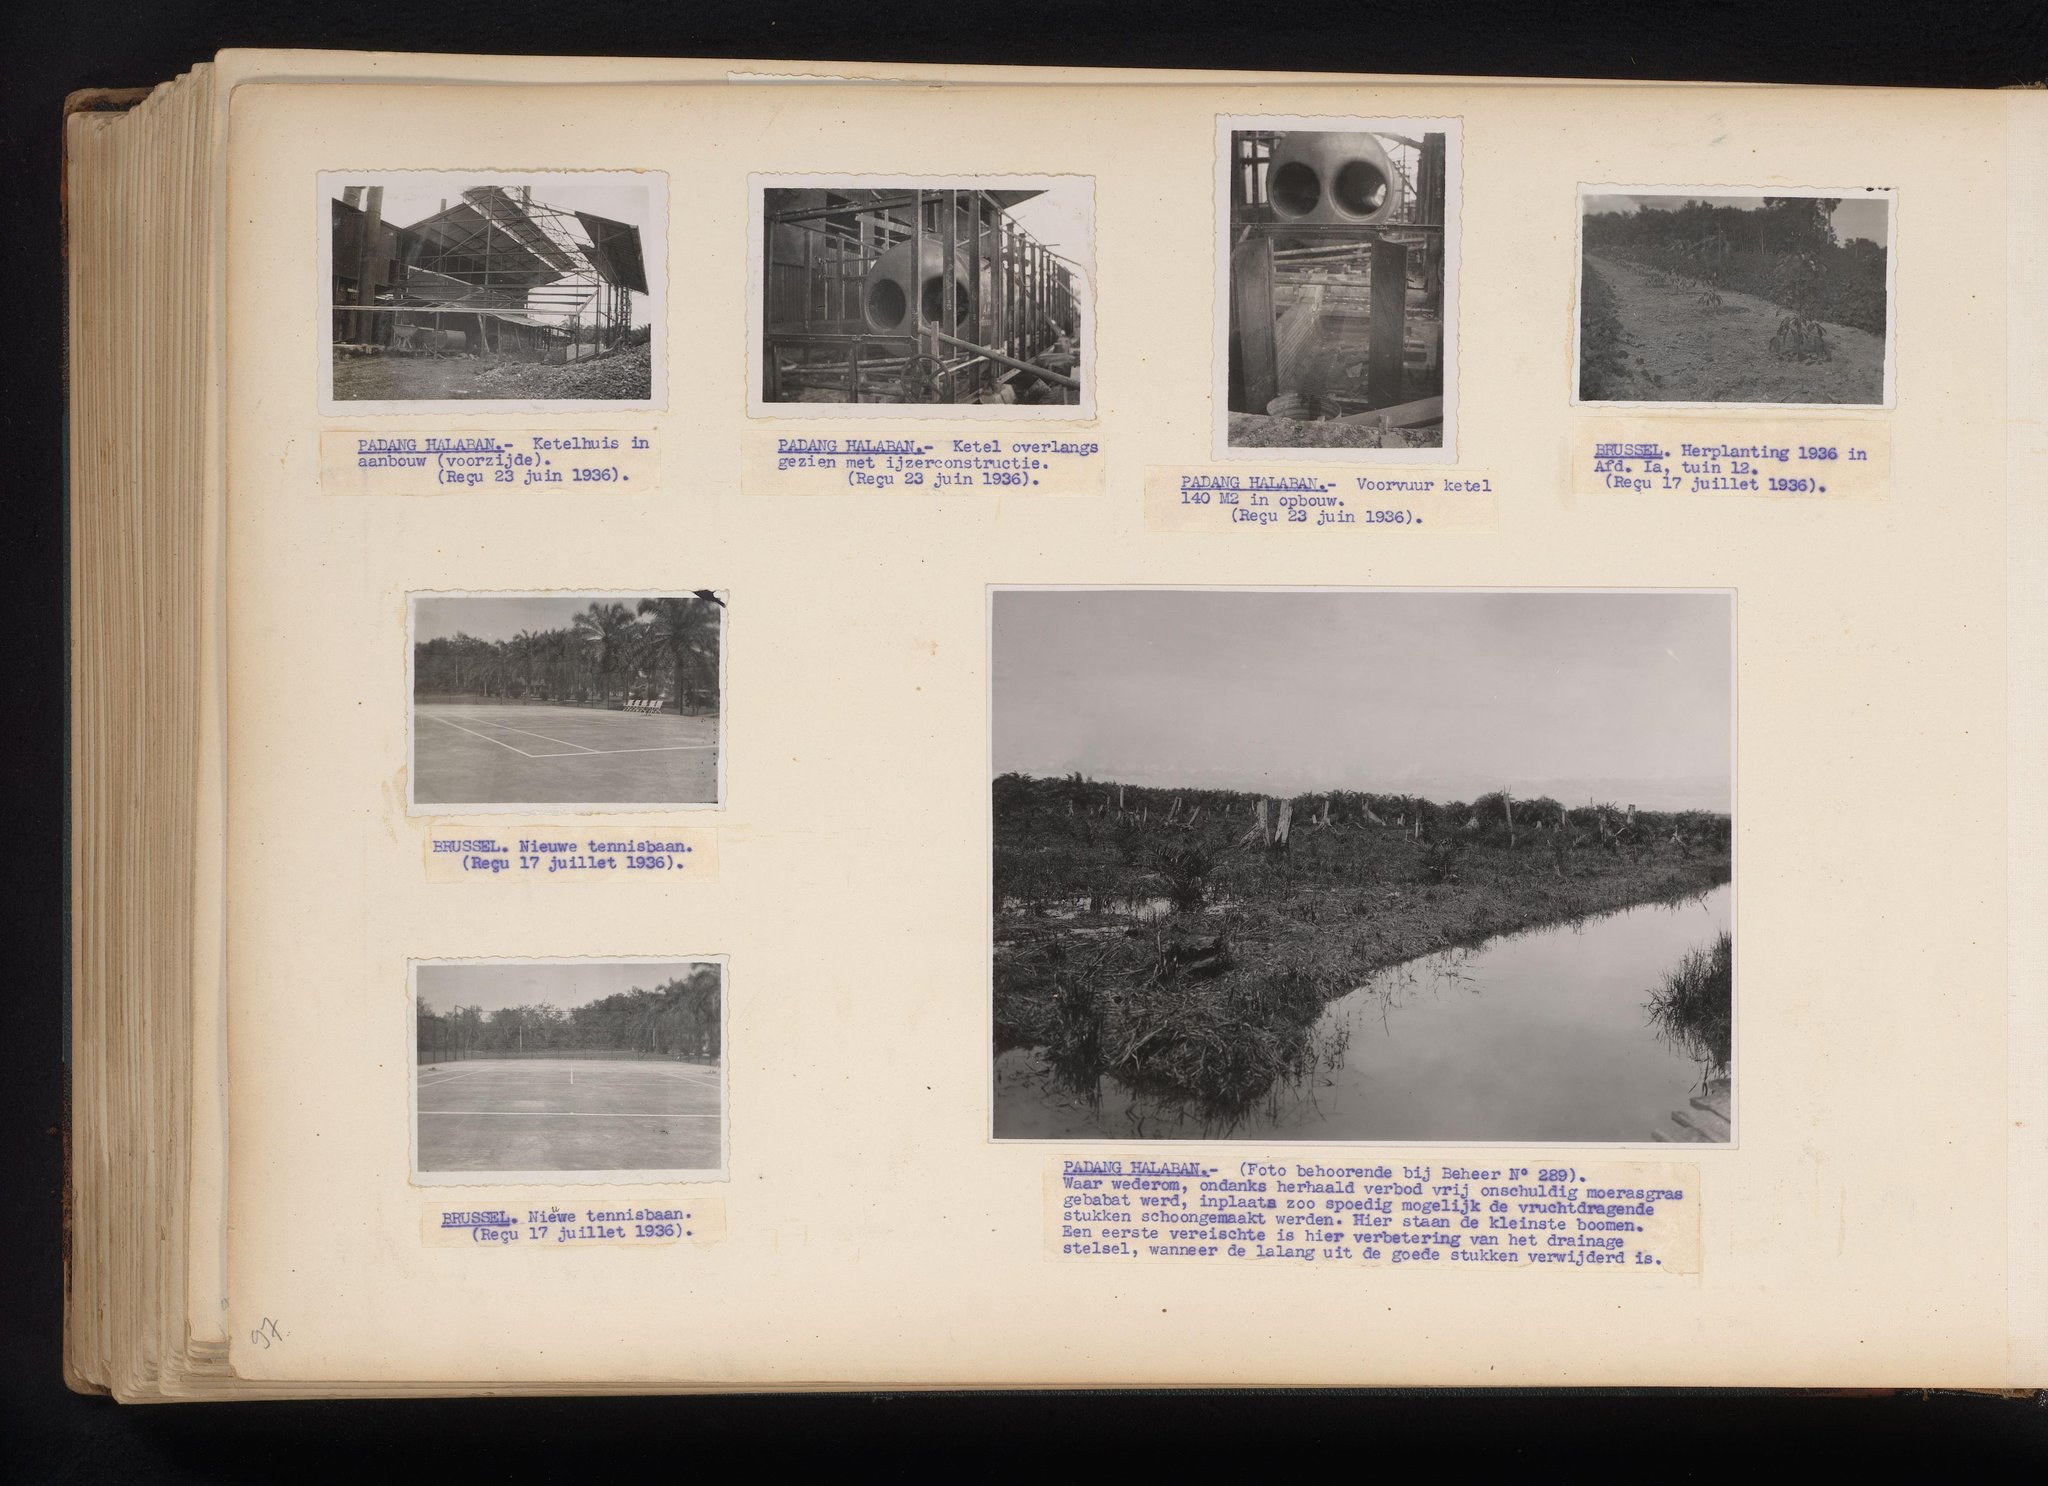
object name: album leaf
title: Installatie van ketel op Padang Halaban en aanleg tennisbaan op Brussel, 1936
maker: Anonymous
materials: cardboard, photographic support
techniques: gelatin silver print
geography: sumatra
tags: plantation, tennis, lawn-tennis, (non-fruit) products of plants or trees: rubber, parts of machines, (non-fruit) products of plants or trees: palm oil, sumatra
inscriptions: inscription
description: Blad met zeven foto's van de installatie van de nieuwe ketel op Padang Halaban en de aanleg van een tennisbaan op Brussel, 1936. Met etiketten met onderschriften onder de foto's. Onderdeel van het fotoalbum over de plantages Brussel en Pernantian van de Sumatra Caoutchouc Maatschappij op de Oostkust van Sumatra in de jaren 1910-1935.